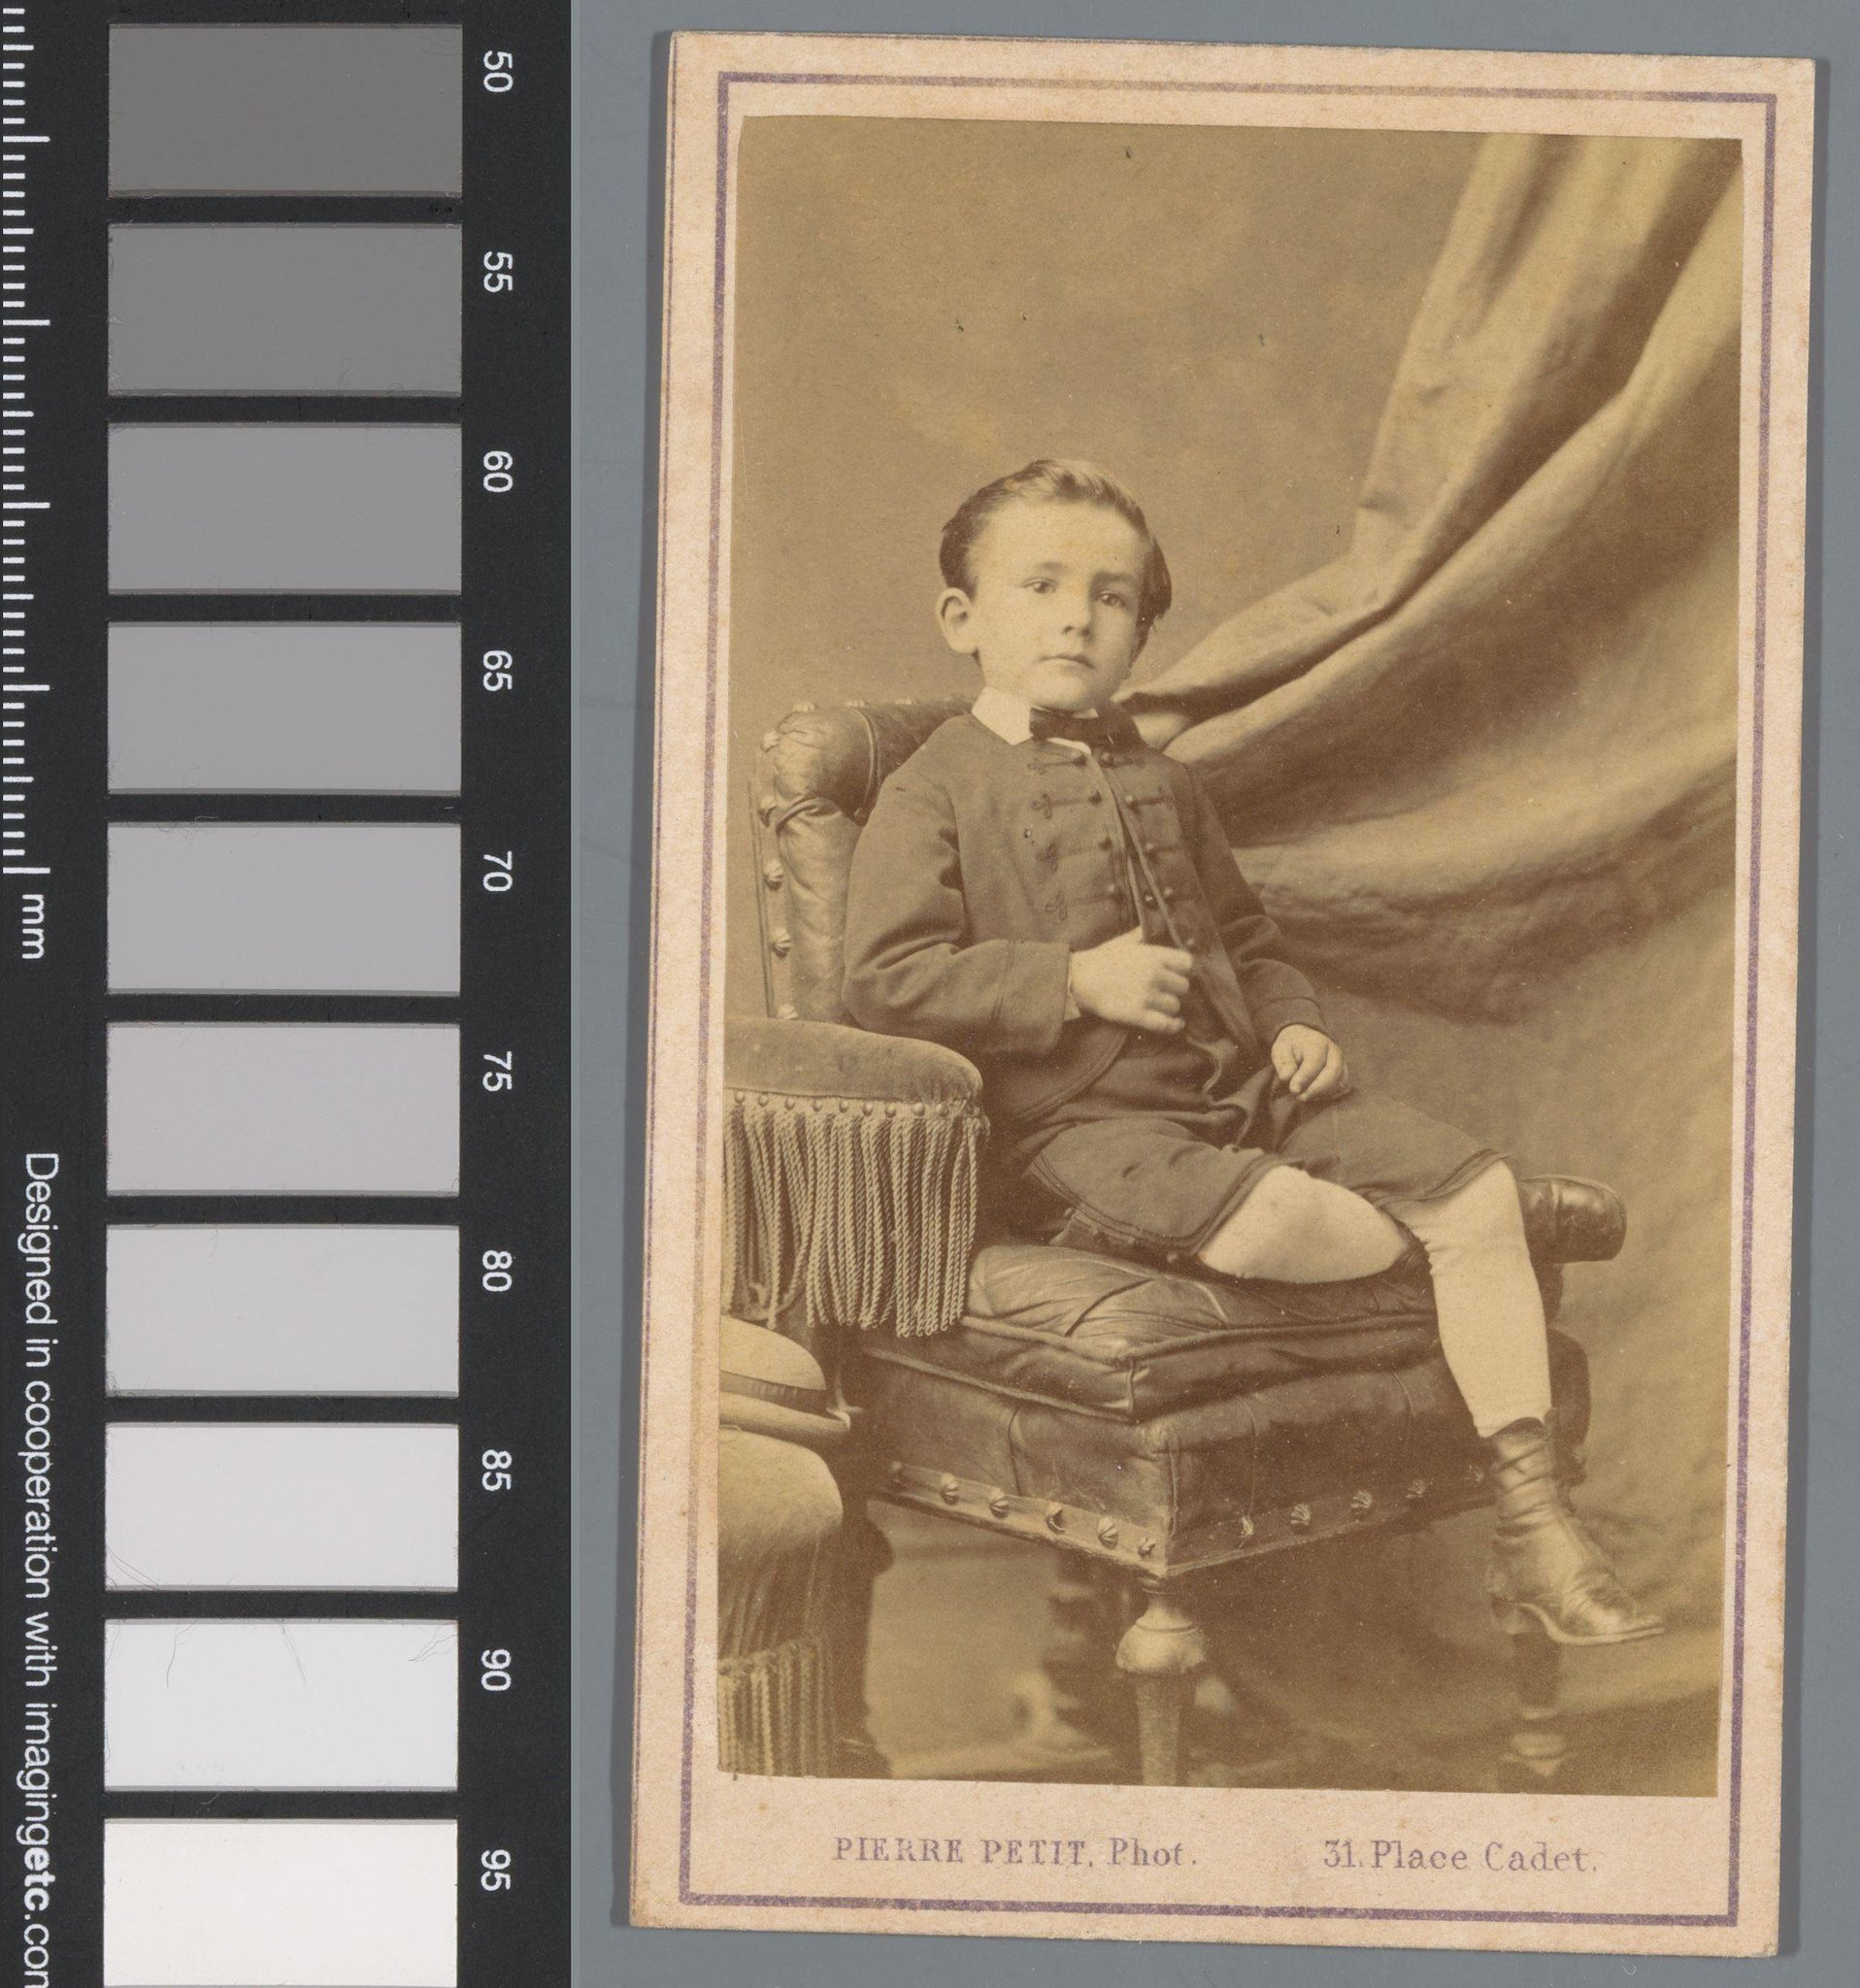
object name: photograph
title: Portret van een onbekende jongen, aangeduid als Edouard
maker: pierre petit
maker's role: fotograaf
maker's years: 1832-1909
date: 1860-1875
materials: cardboard, paper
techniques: albumen print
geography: paris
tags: boy (child between toddler and youth), historical persons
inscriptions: inscription: ‘EXPOSITION UNIVERSELLE 1867/ PIERRE PETIT/ OPÈRE LUI MÊME/ 31, Place Cadet/ PARIS’, inscription: ‘Edouard à 7 ans’